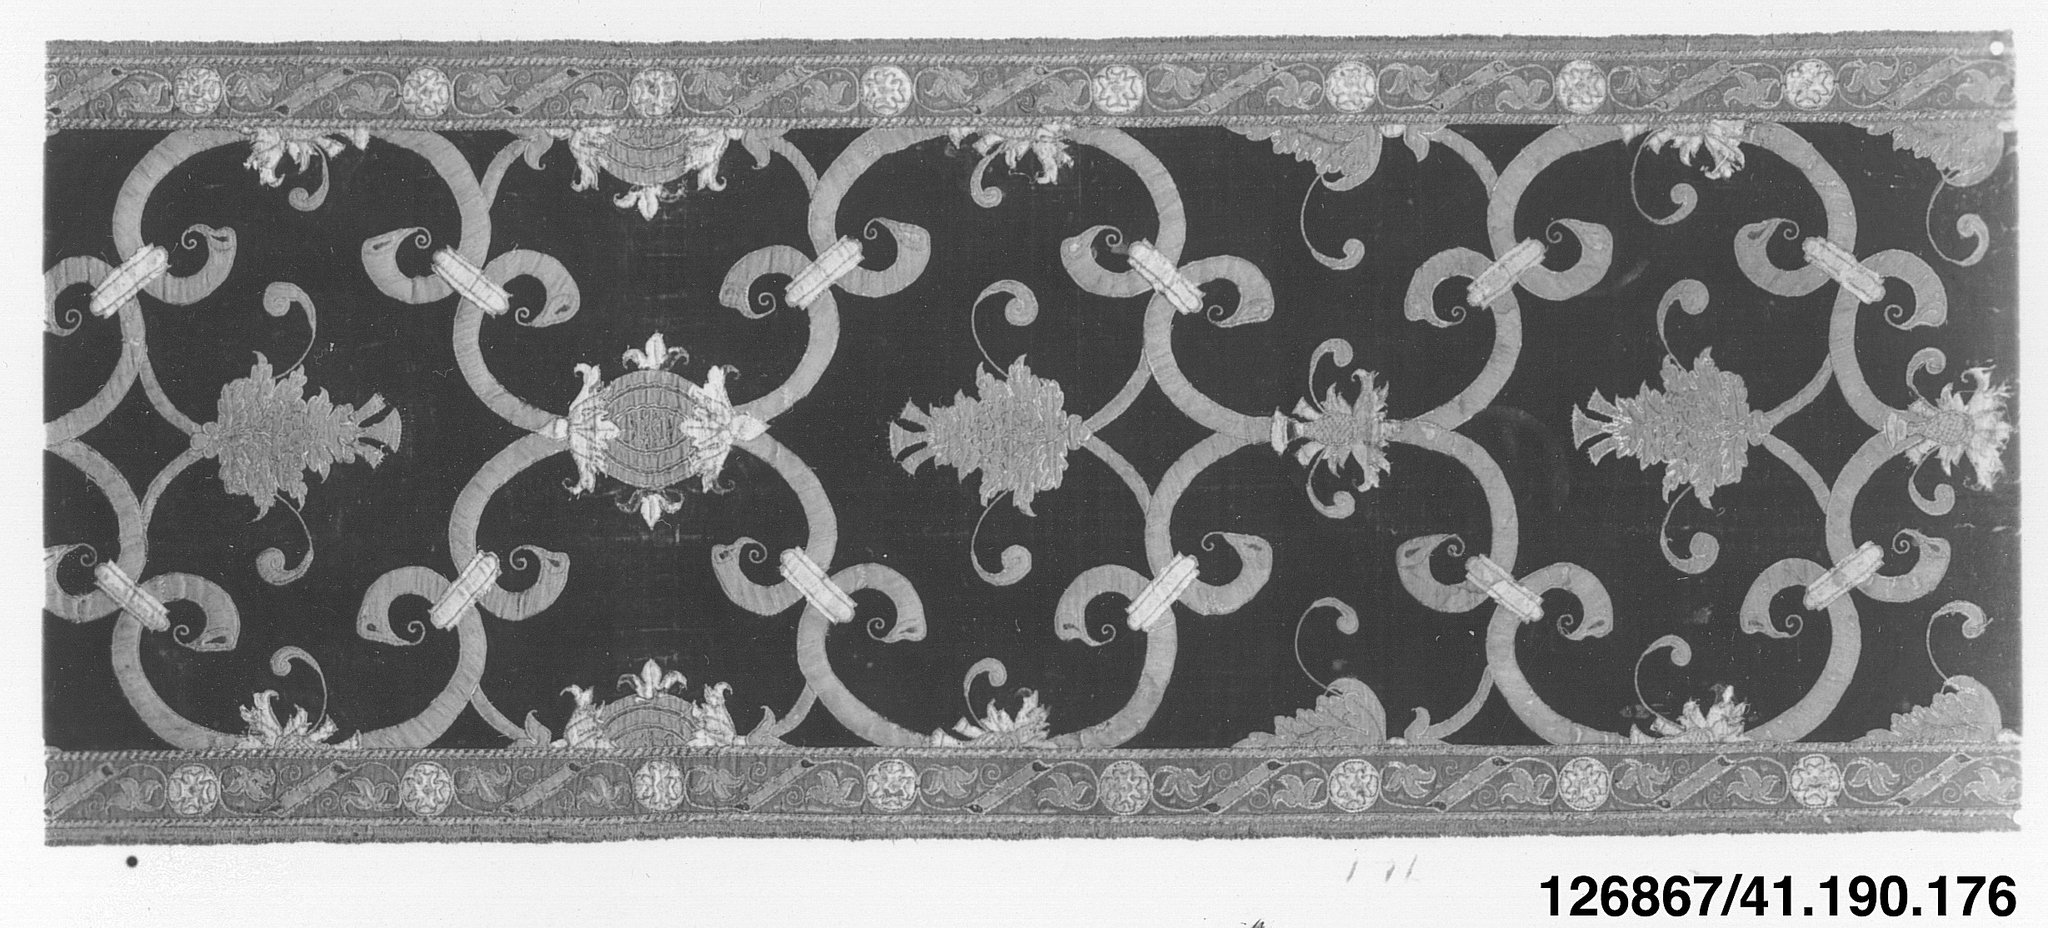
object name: panel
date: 1601-1700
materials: metal thread, silk, velvet